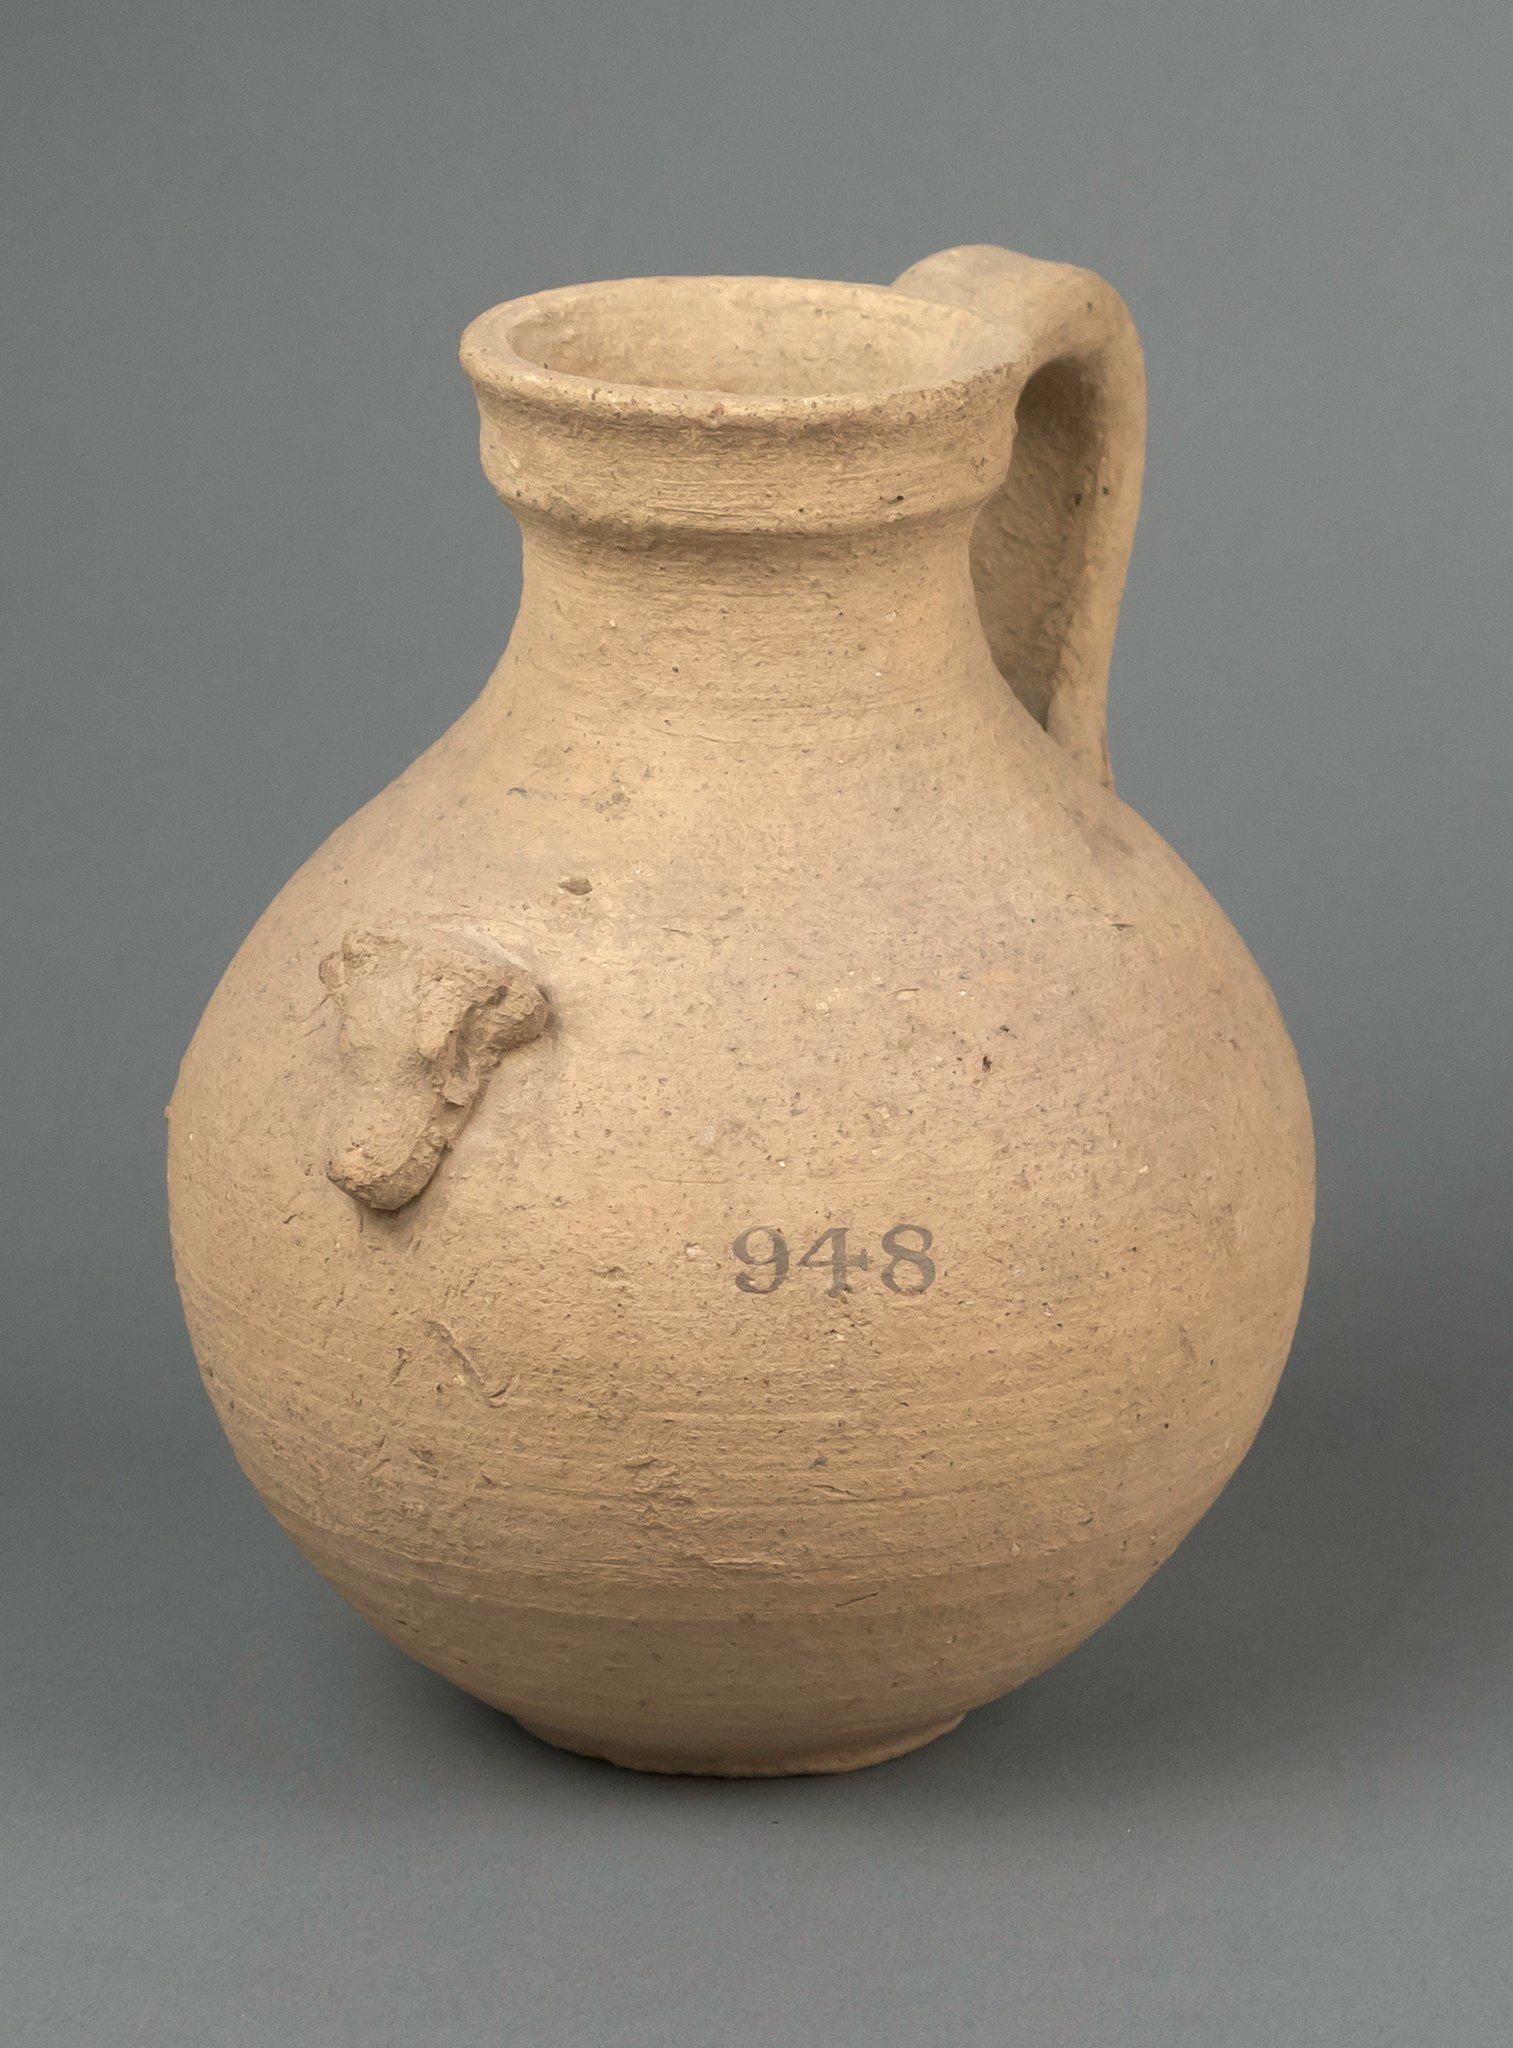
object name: jug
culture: cypriot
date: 600-480 BCE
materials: terracotta